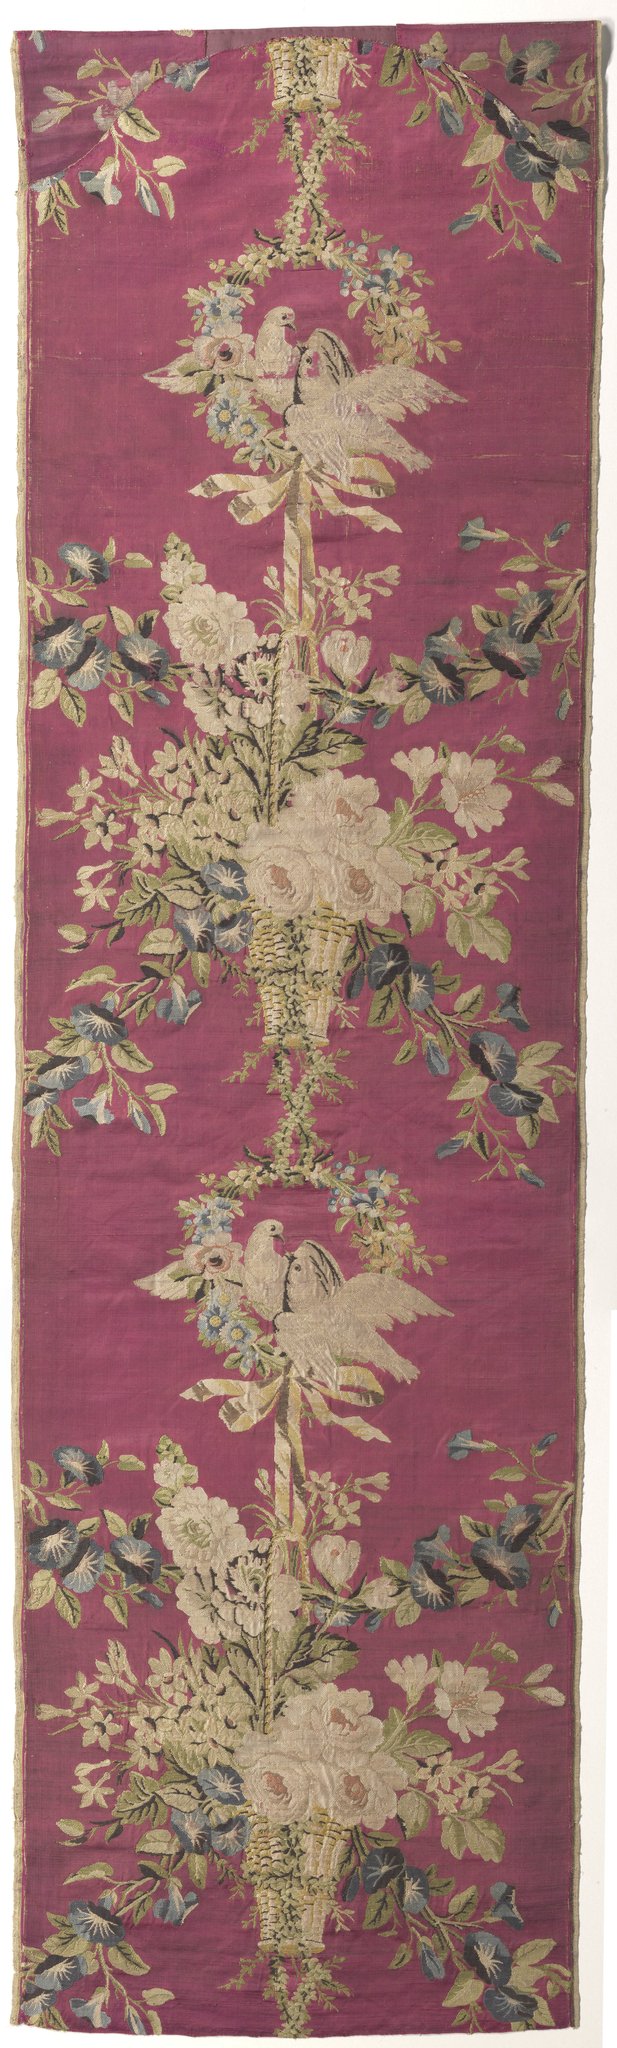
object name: upholstered wall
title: Wandbespanning van lampas met tortelduivenpatroon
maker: philippe de lasalle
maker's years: 1723-1805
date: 1770-1790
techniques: lampas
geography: lyon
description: Wandbespanning, bestaande uit een baan lampas. Tortelduifpatroon.